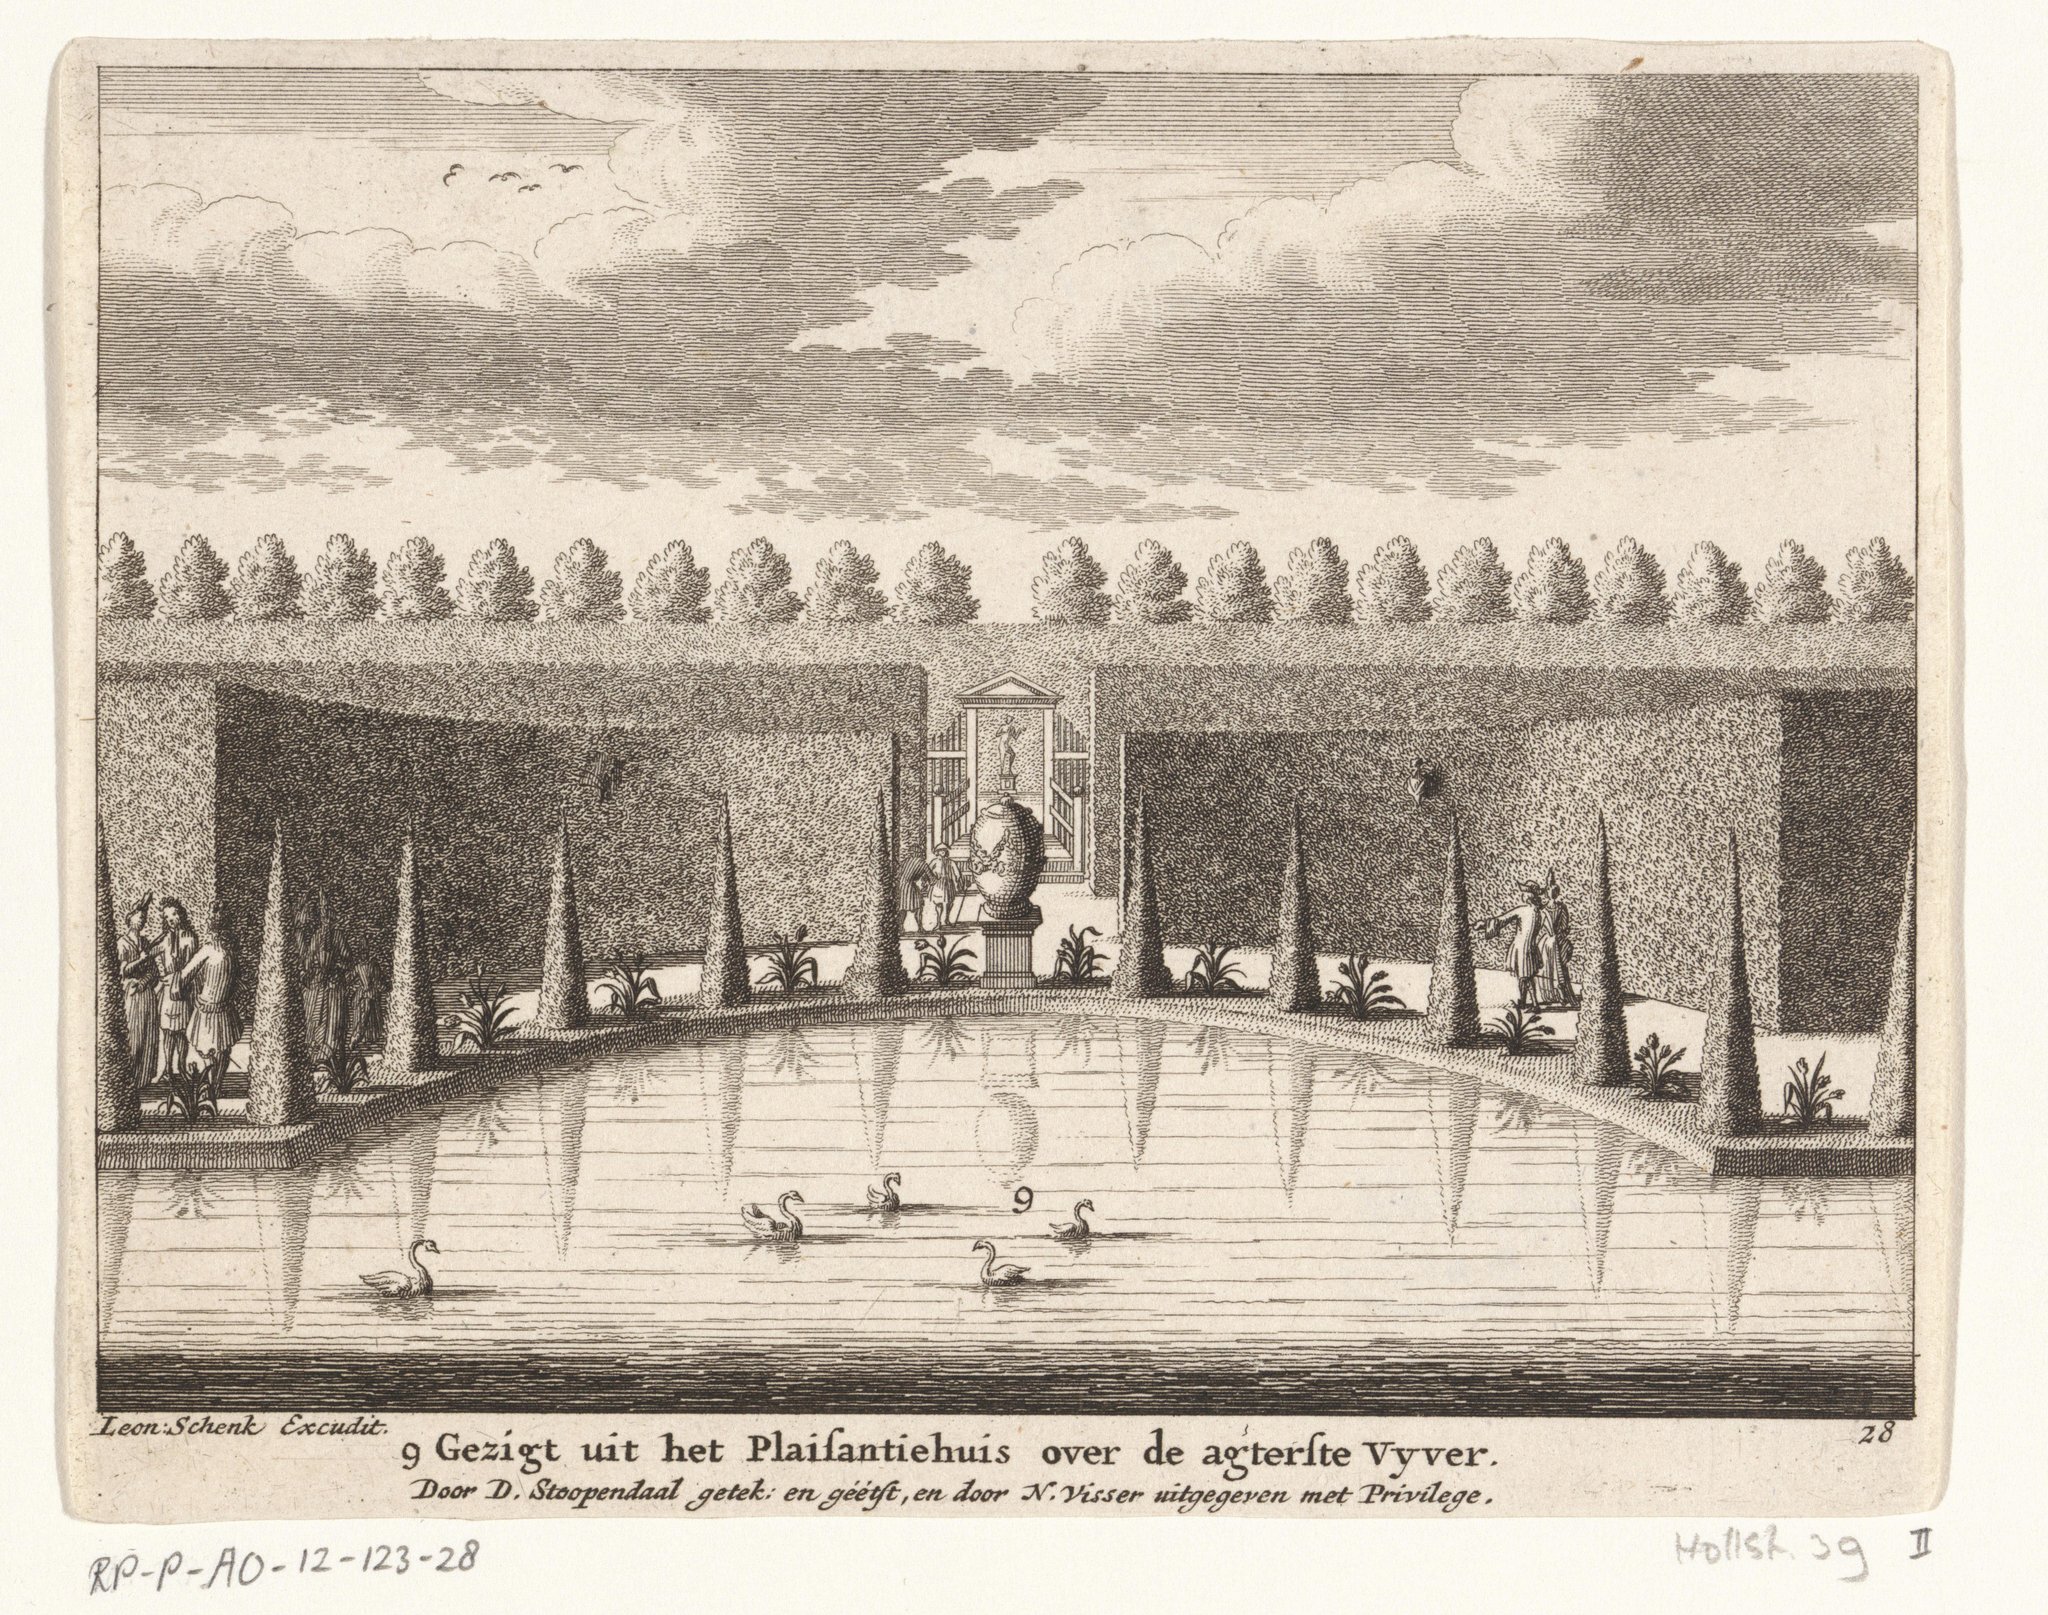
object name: print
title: Gezigt uit het Plaisantiehuis over de agterste Vyver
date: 1682-1726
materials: paper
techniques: etching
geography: amsterdam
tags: french or architectonic garden; formal garden, garden pond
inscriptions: collector's mark: Lugt 2228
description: Gezicht vanuit een tuinhuis op de achterste vijver op landgoed Clingendael te Den Haag.